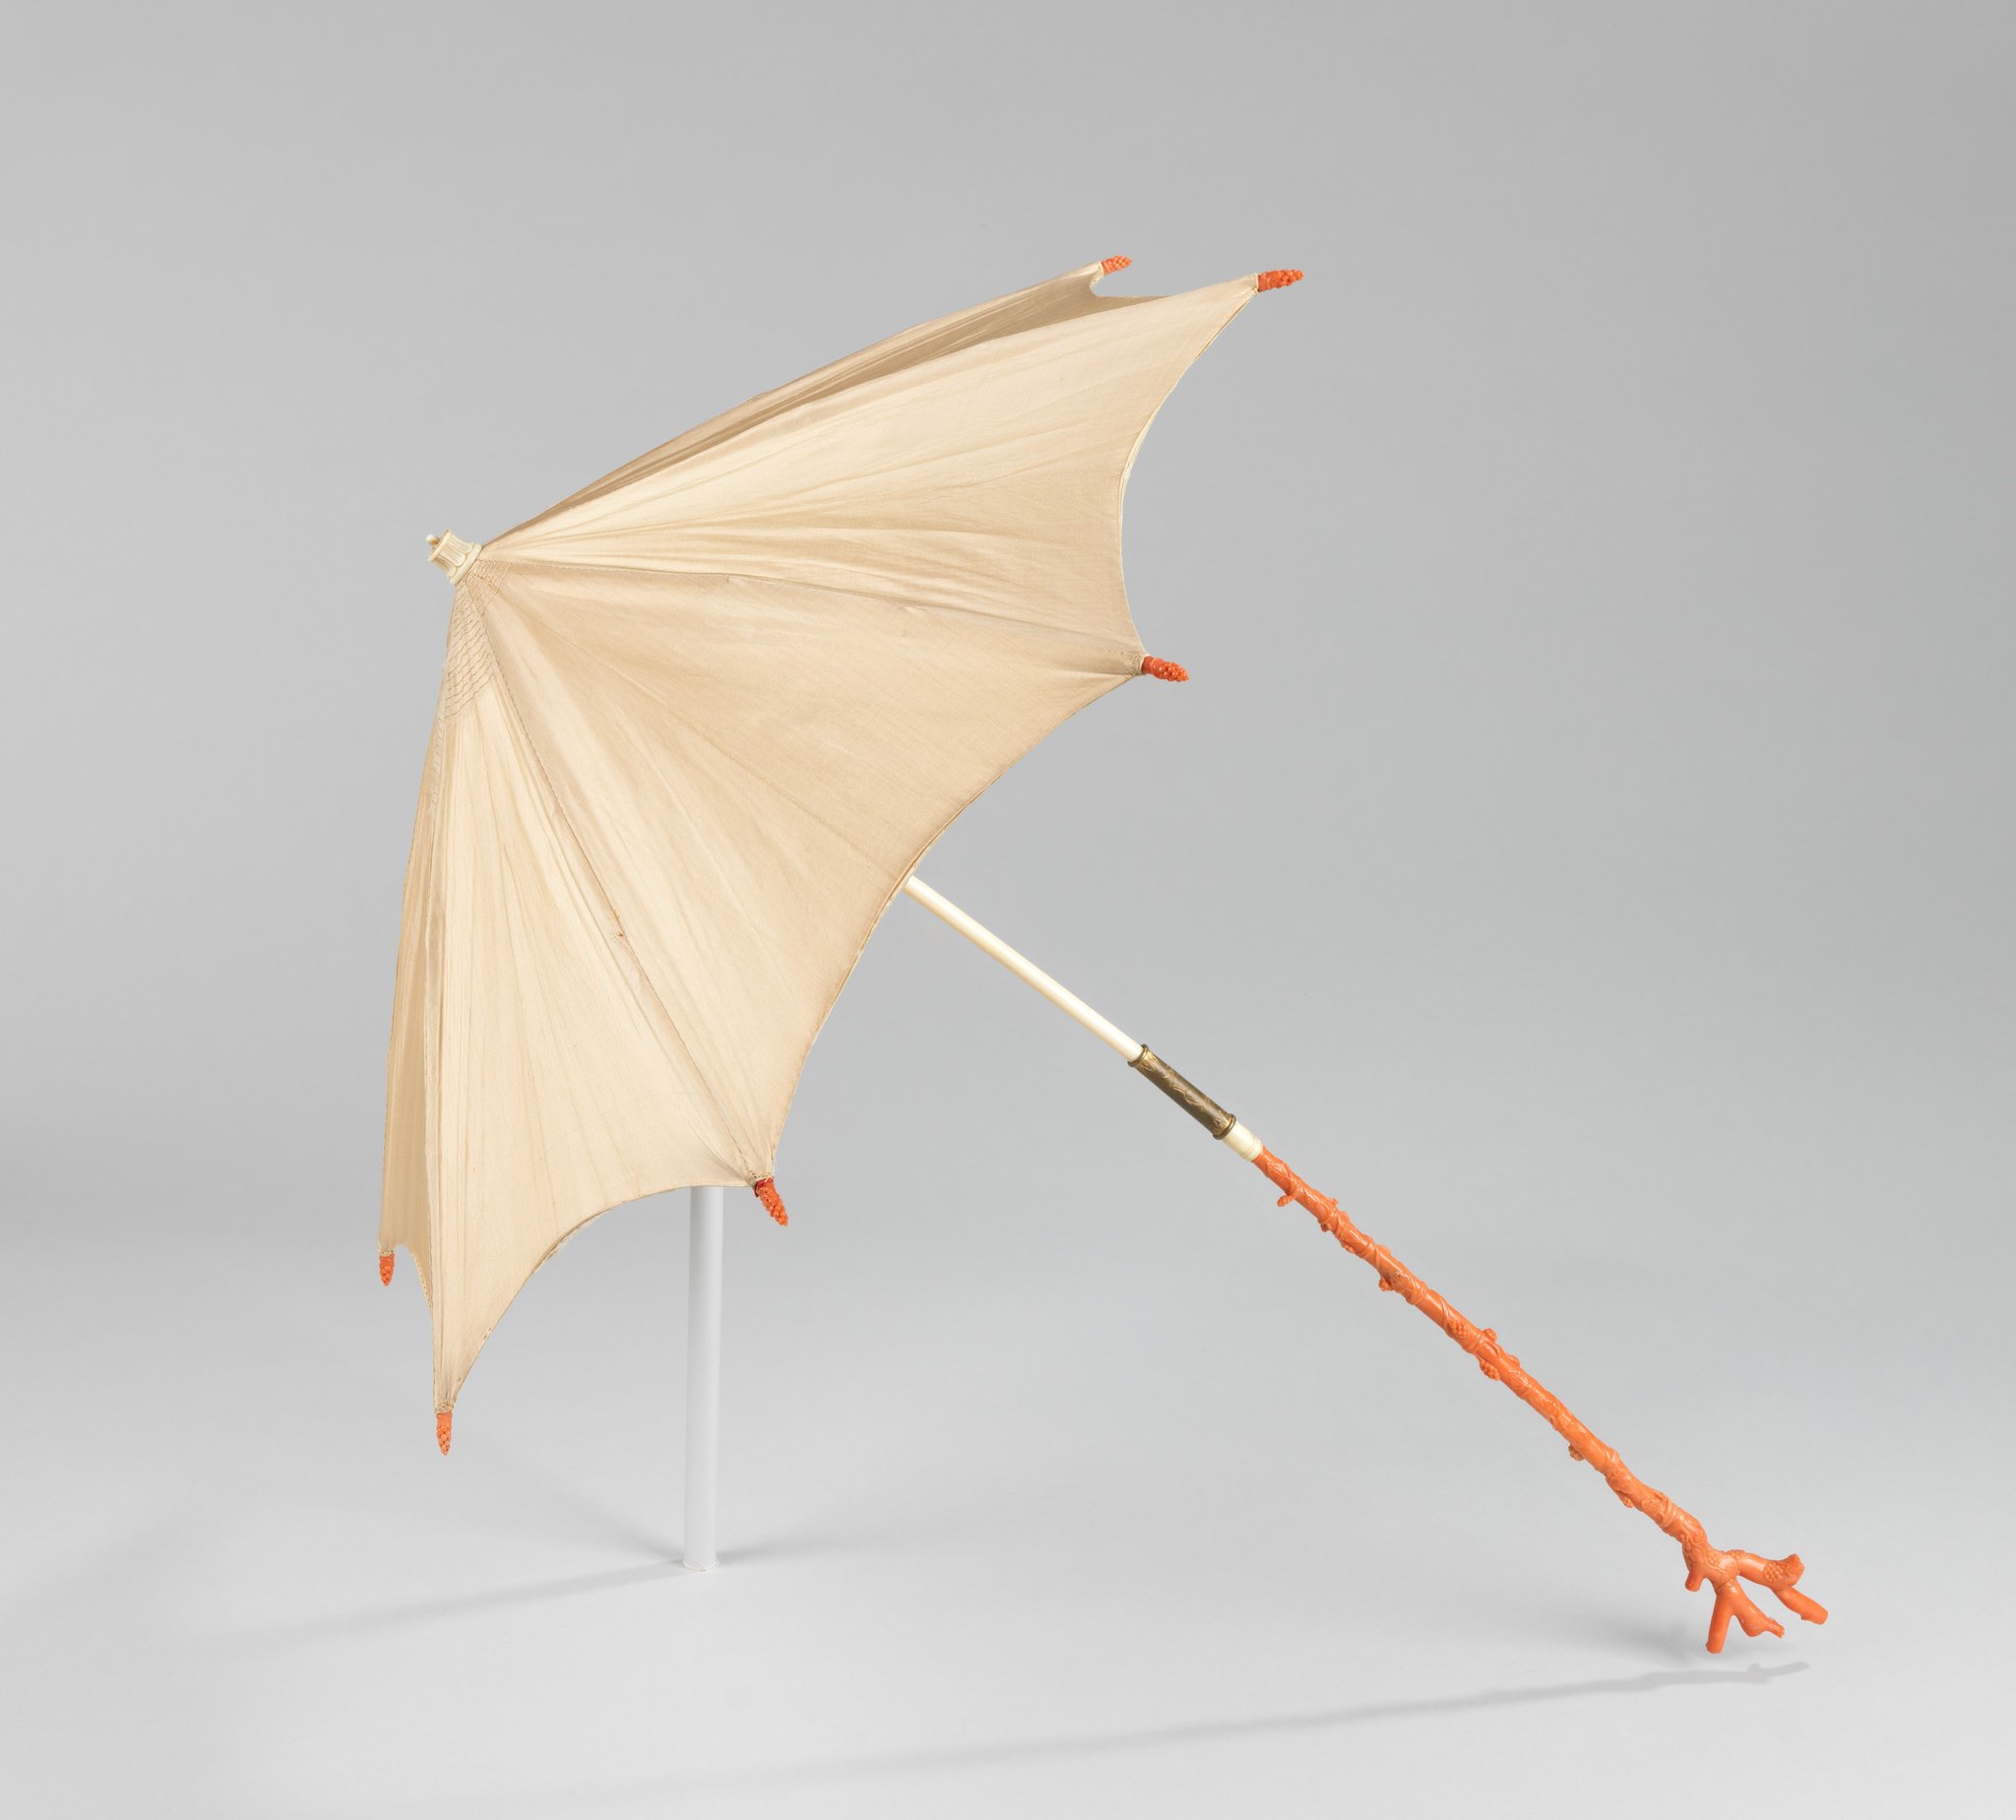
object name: parasol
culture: french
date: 1855-1865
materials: coral, ivory, metal, silk